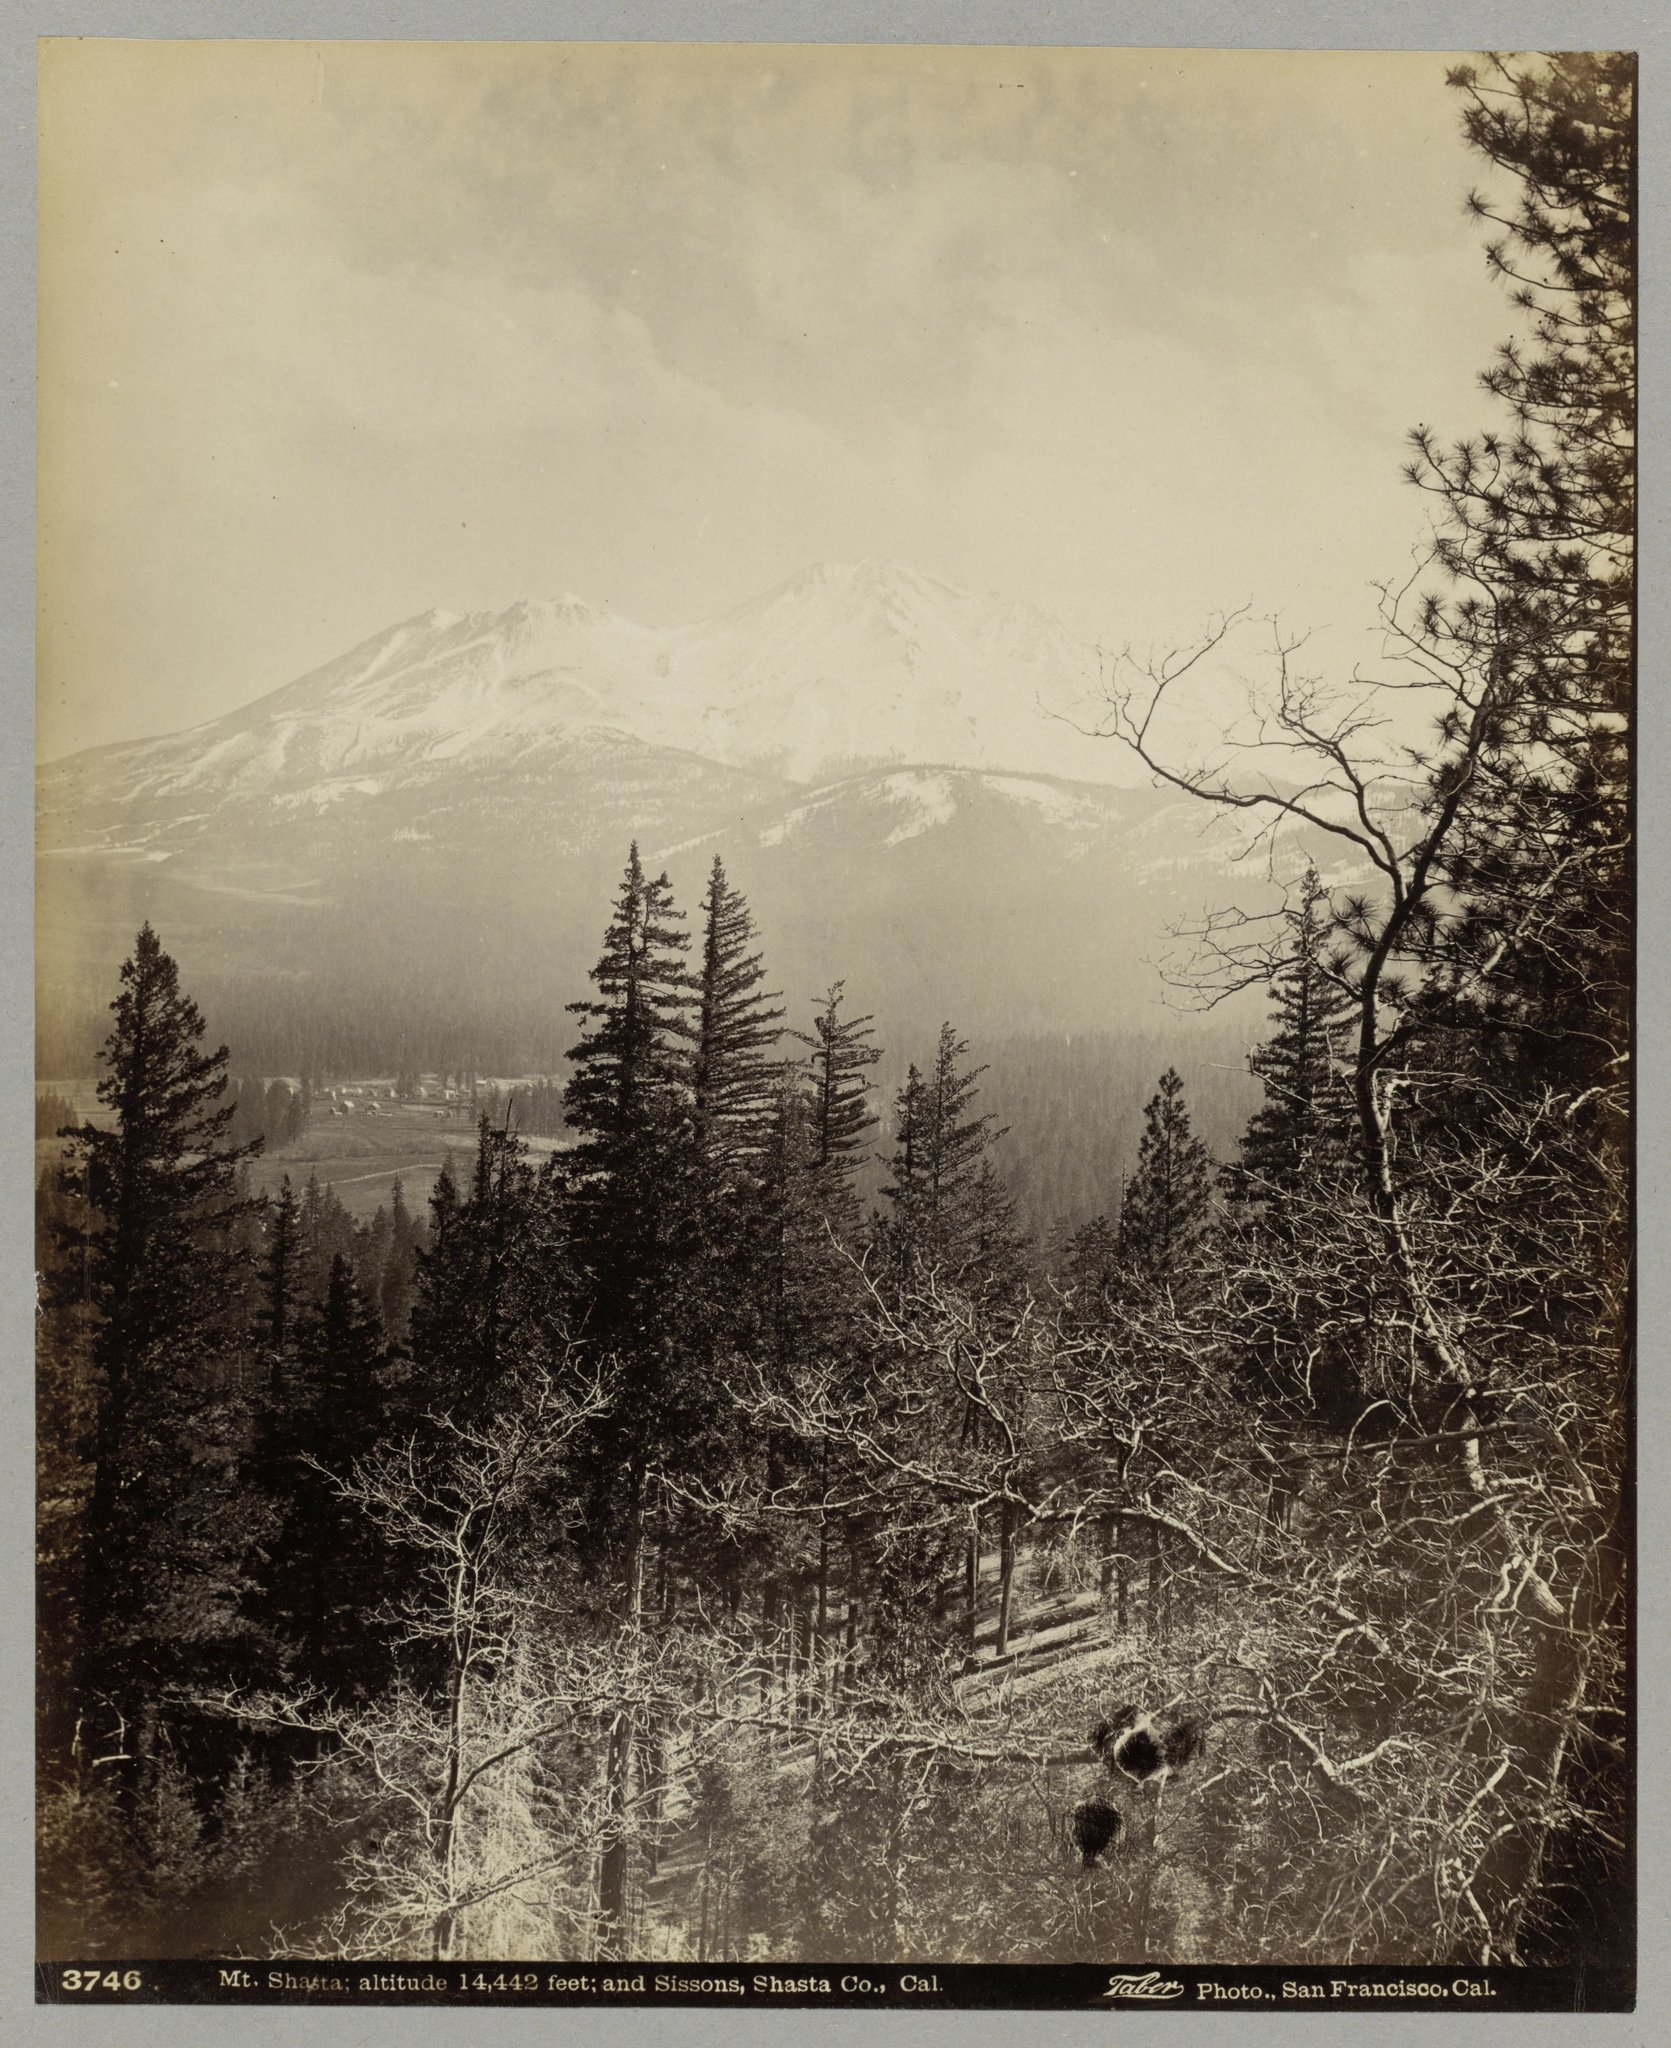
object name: photograph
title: Mt. Shasta; altitude 14,442 feet; and Sissons, Shasta Co.. Cal.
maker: isaiah west taber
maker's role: fotograaf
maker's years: 1830-1912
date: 1880-1900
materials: cardboard, paper, photographic support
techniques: albumen print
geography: california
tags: mountains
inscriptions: negative number: ‘3746’